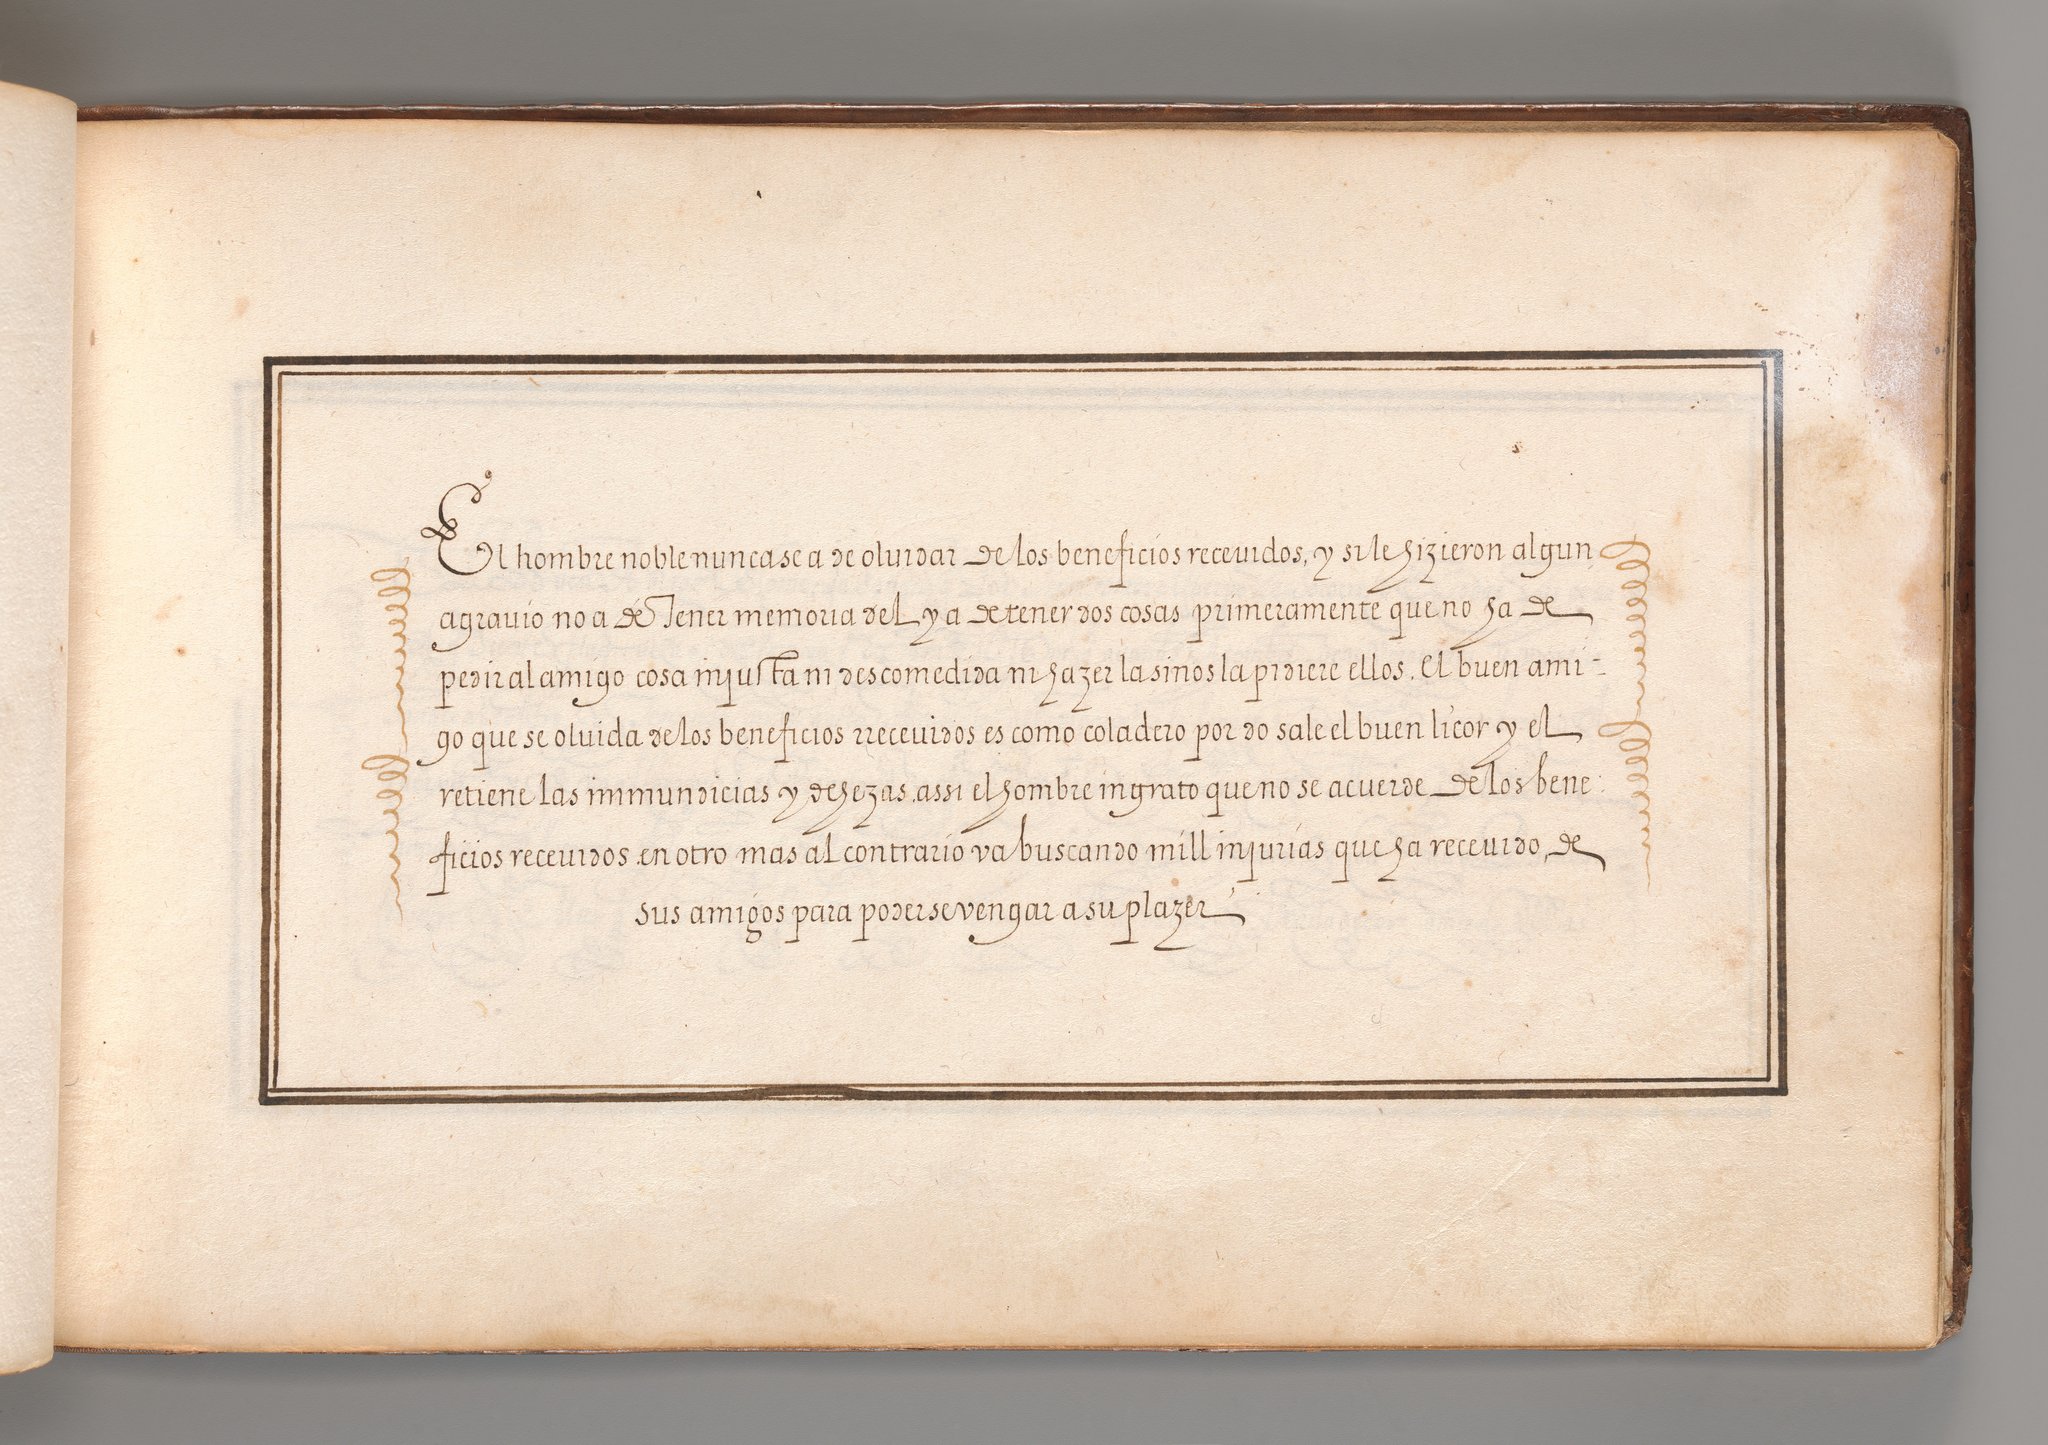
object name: album print ornament architecture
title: Calligraphic Exercise in Spanish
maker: Anonymous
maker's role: artist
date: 1601-1633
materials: ink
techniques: pen